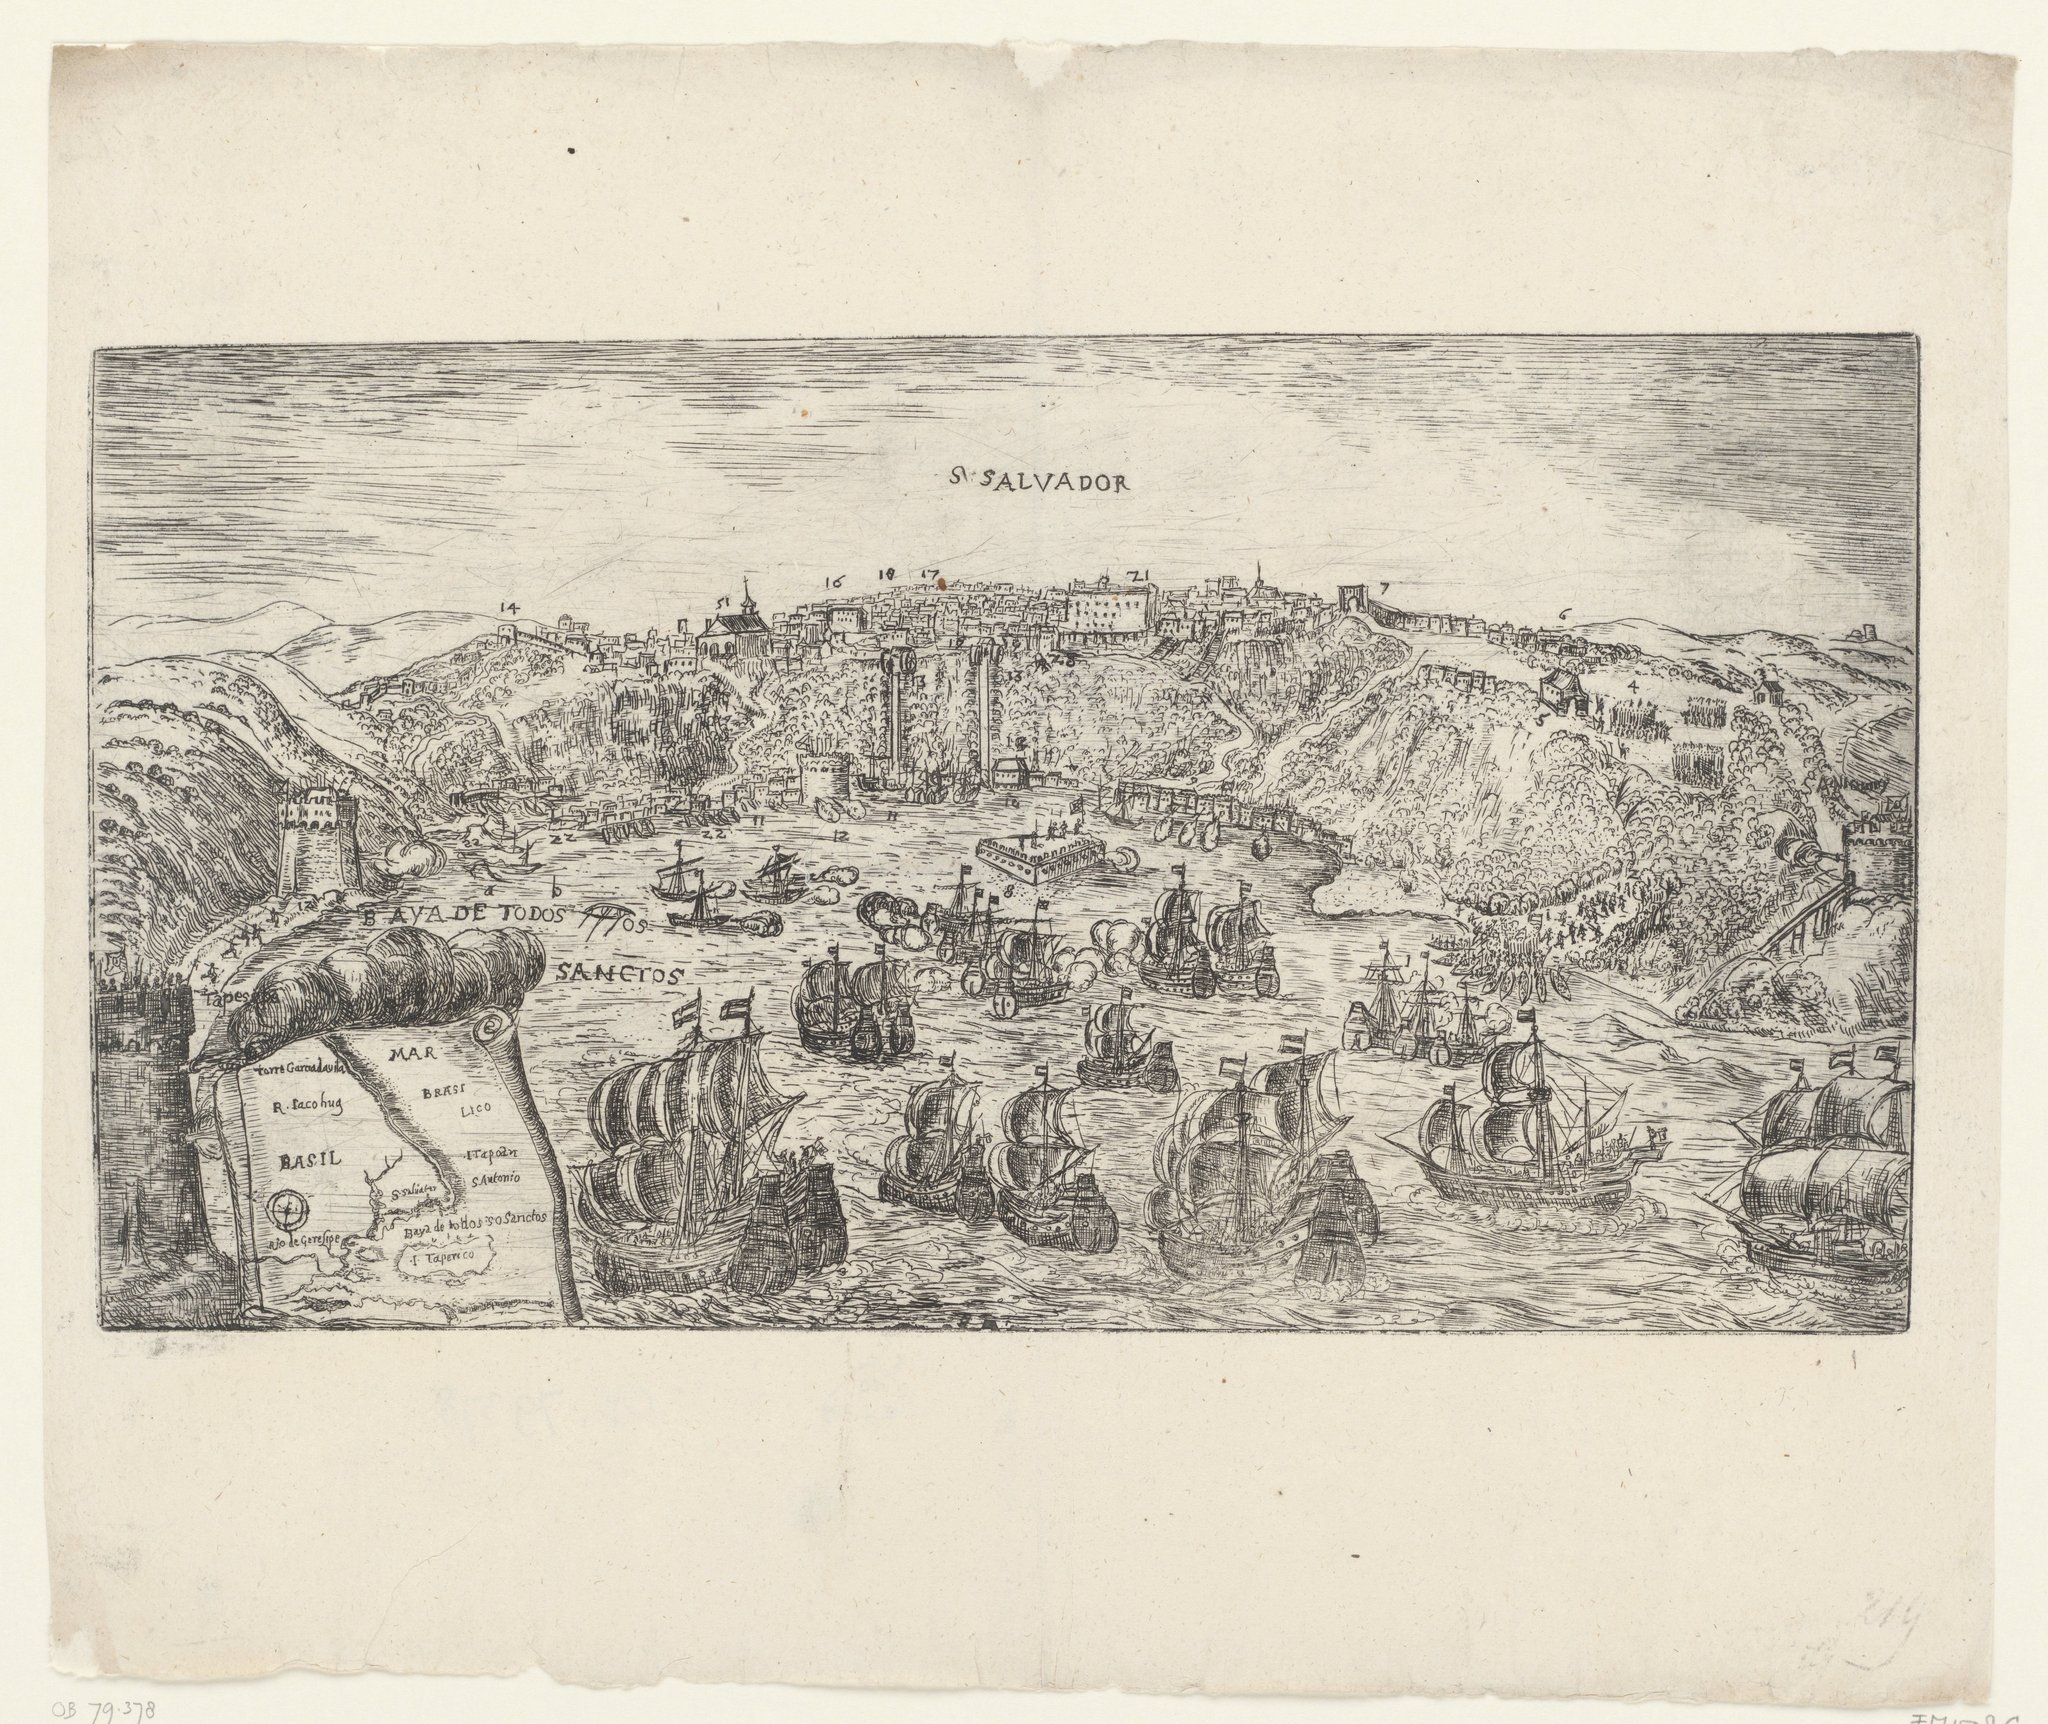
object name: print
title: Verovering van San Salvador in Brazilië door admiraal Jacob Willekes, 1624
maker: Anonymous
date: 1624-1699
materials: paper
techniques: engraving, etching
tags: amsterdam, battle (+ naval force), capture of city (after the siege)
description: De verovering van San Salvador in Brazilië door admiraal Jacob Willekes voor de WIC, 10 mei 1624. Gezicht op de stad en forten aan de ingang van de baai van waaruit de Hollandse vloot beschoten wordt. Linksonder een inzet met een kaartje van het groter gebied.